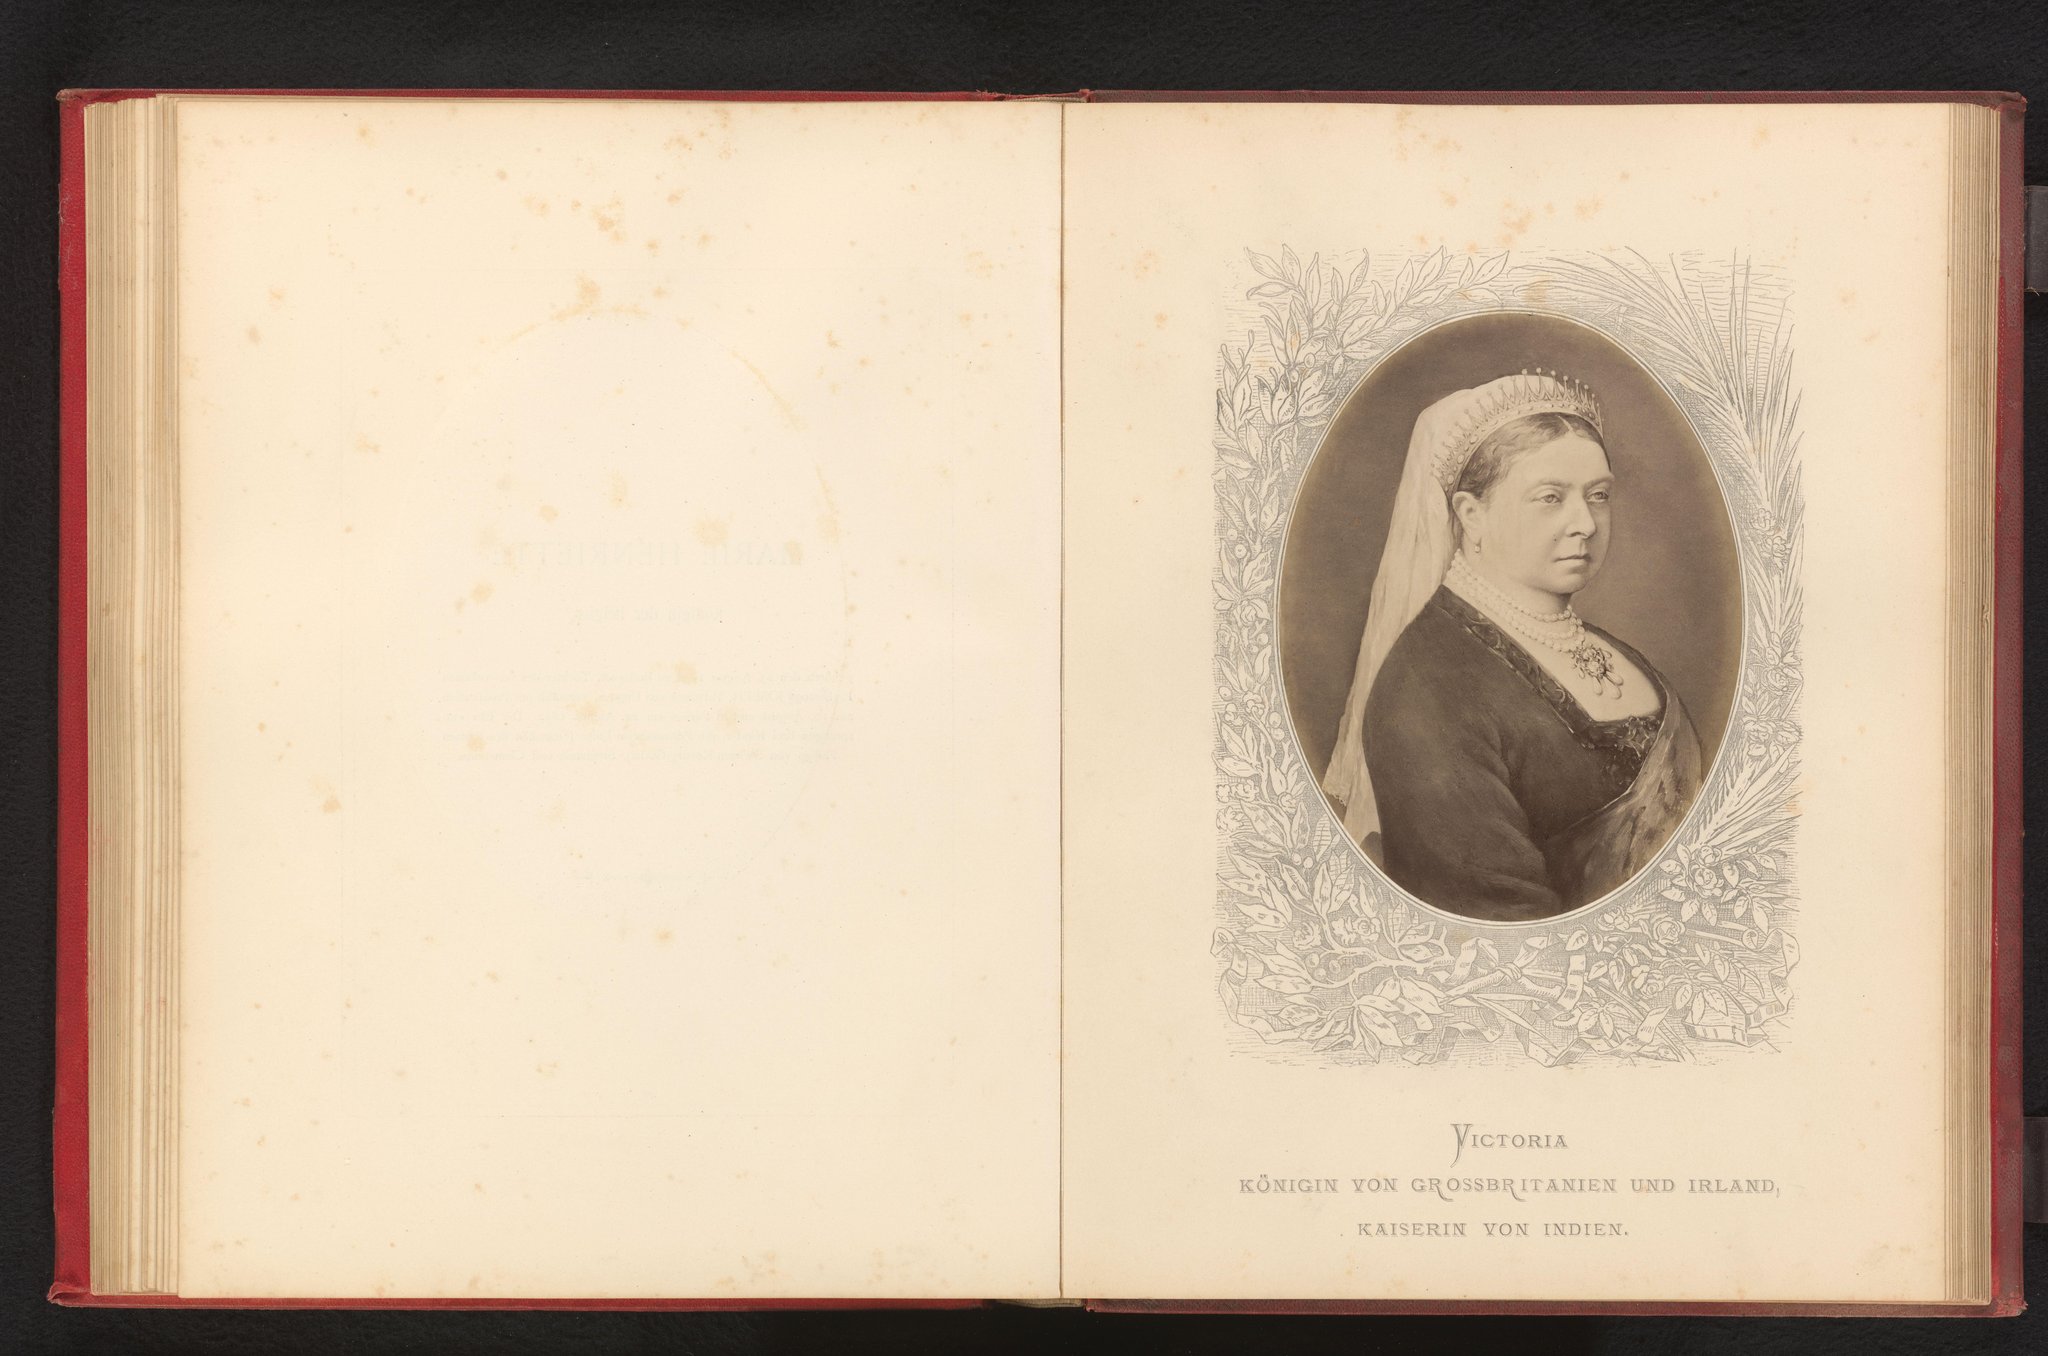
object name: page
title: Fotoreproductie van een geschilderd portret van Victoria, koningin van Groot-Brittanië en Ierland, keizerin van India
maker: Anonymous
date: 1875-1880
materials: paper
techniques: albumen print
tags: victoria (koningin van het verenigd koninkrijk en keizerin van india), historical persons - bb - woman, queen